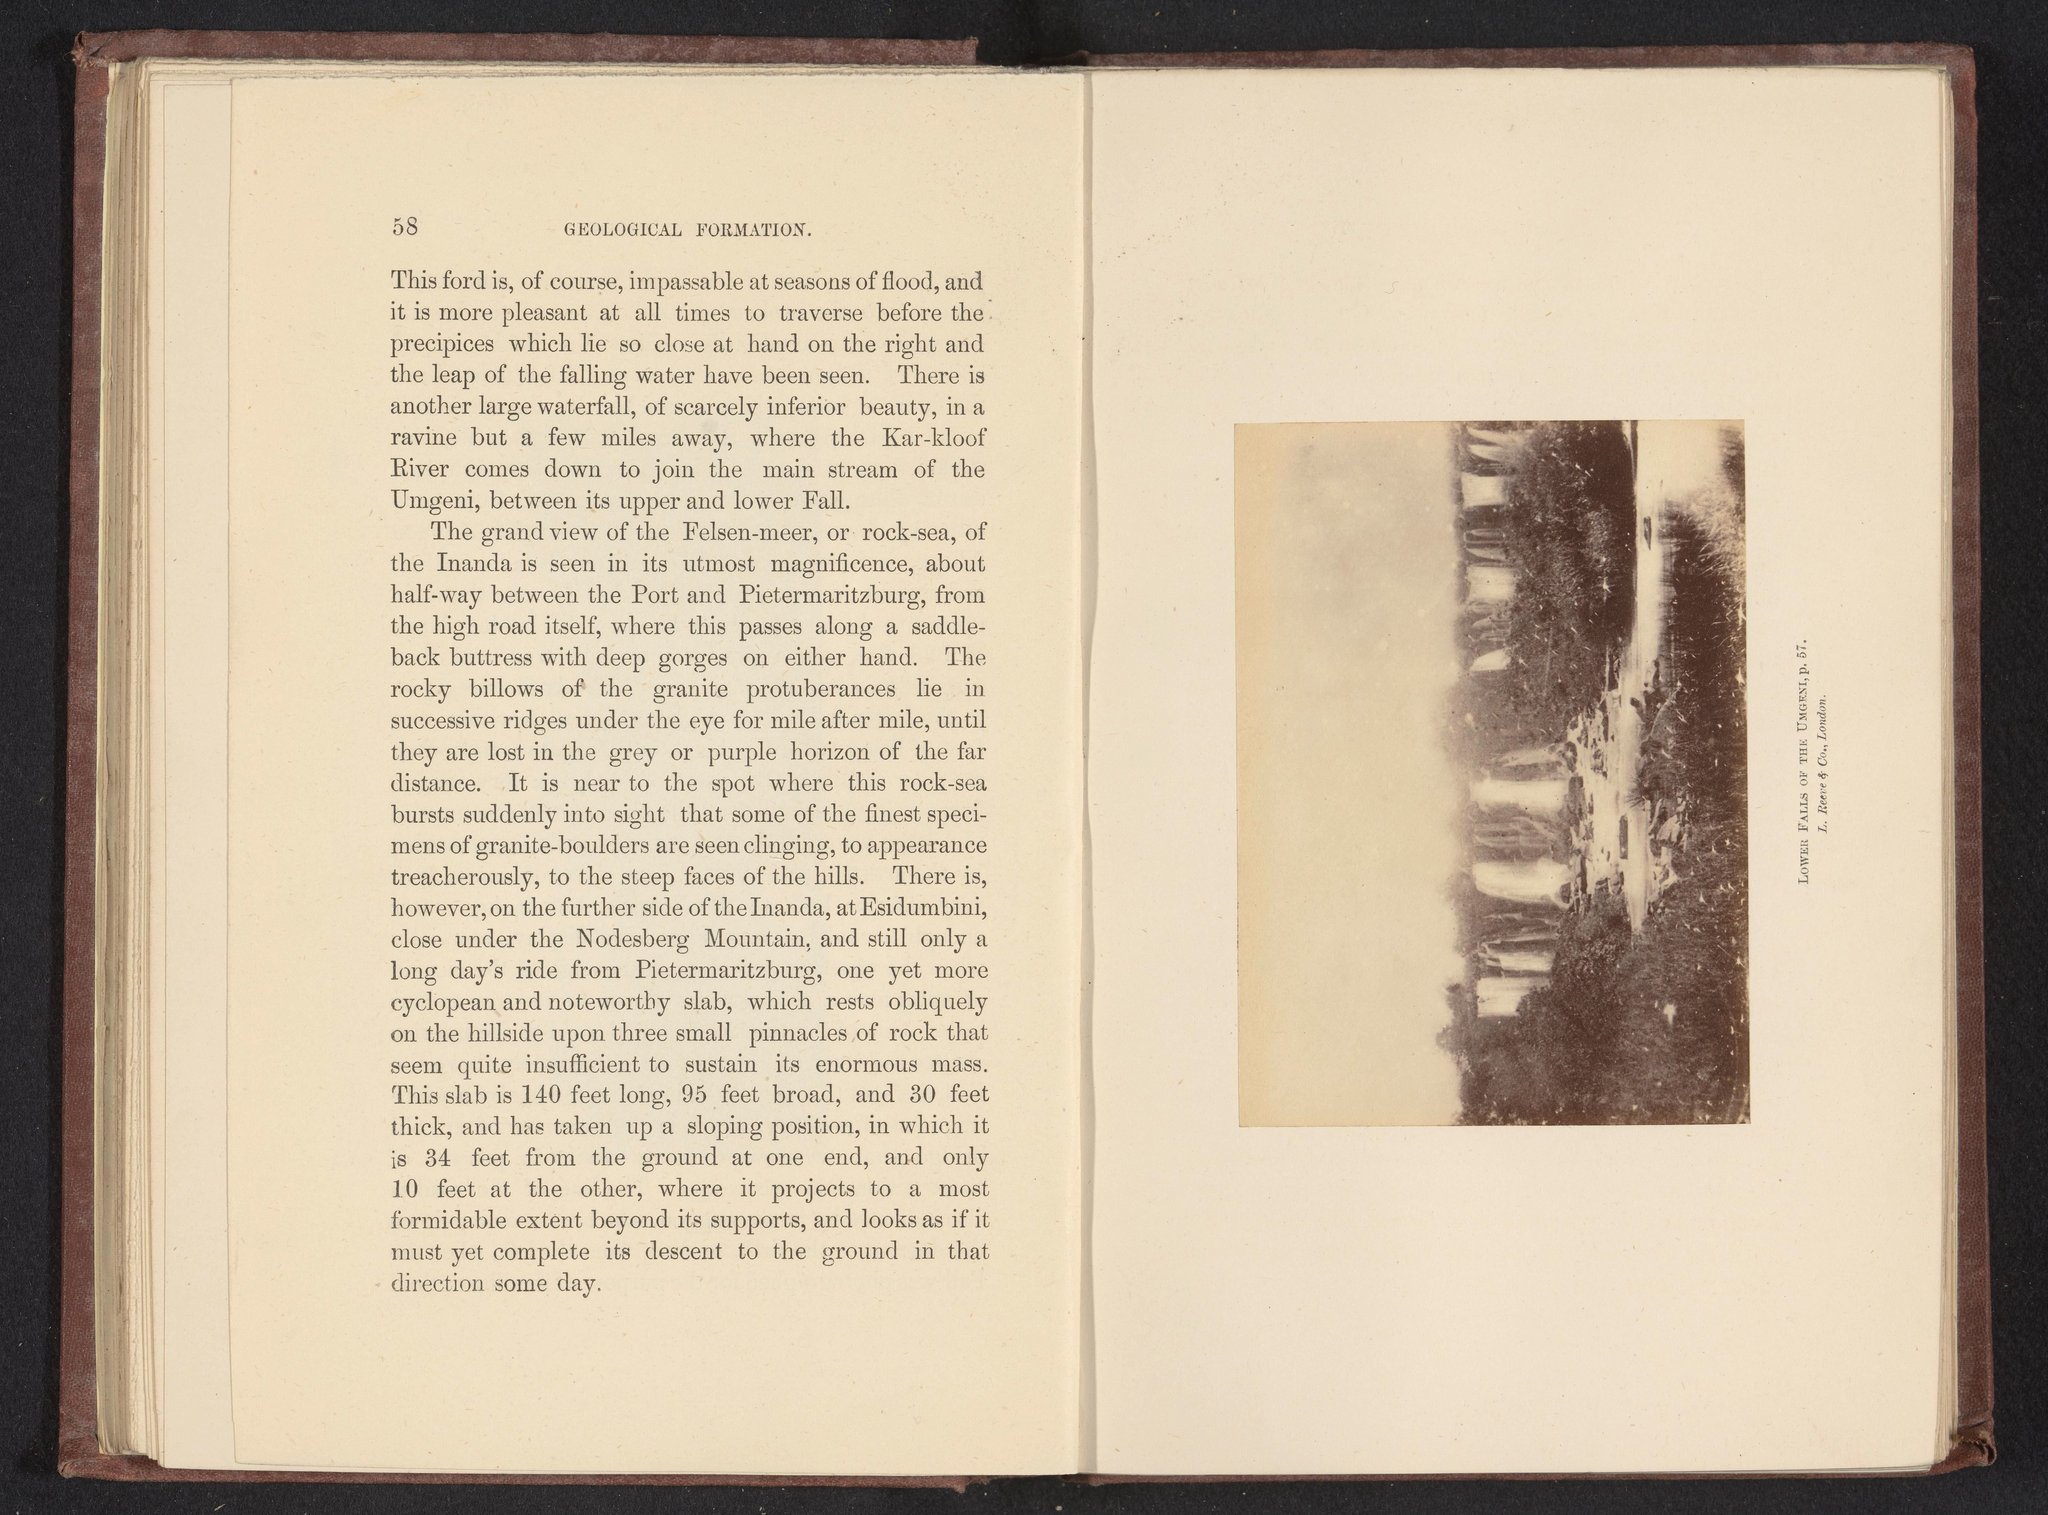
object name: page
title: Lower falls of the Umgeni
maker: Anonymous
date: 1866-1876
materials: photographic support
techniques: albumen print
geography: natal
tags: river, waterfall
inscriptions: name: ‘L. Reeve & Co., London.’